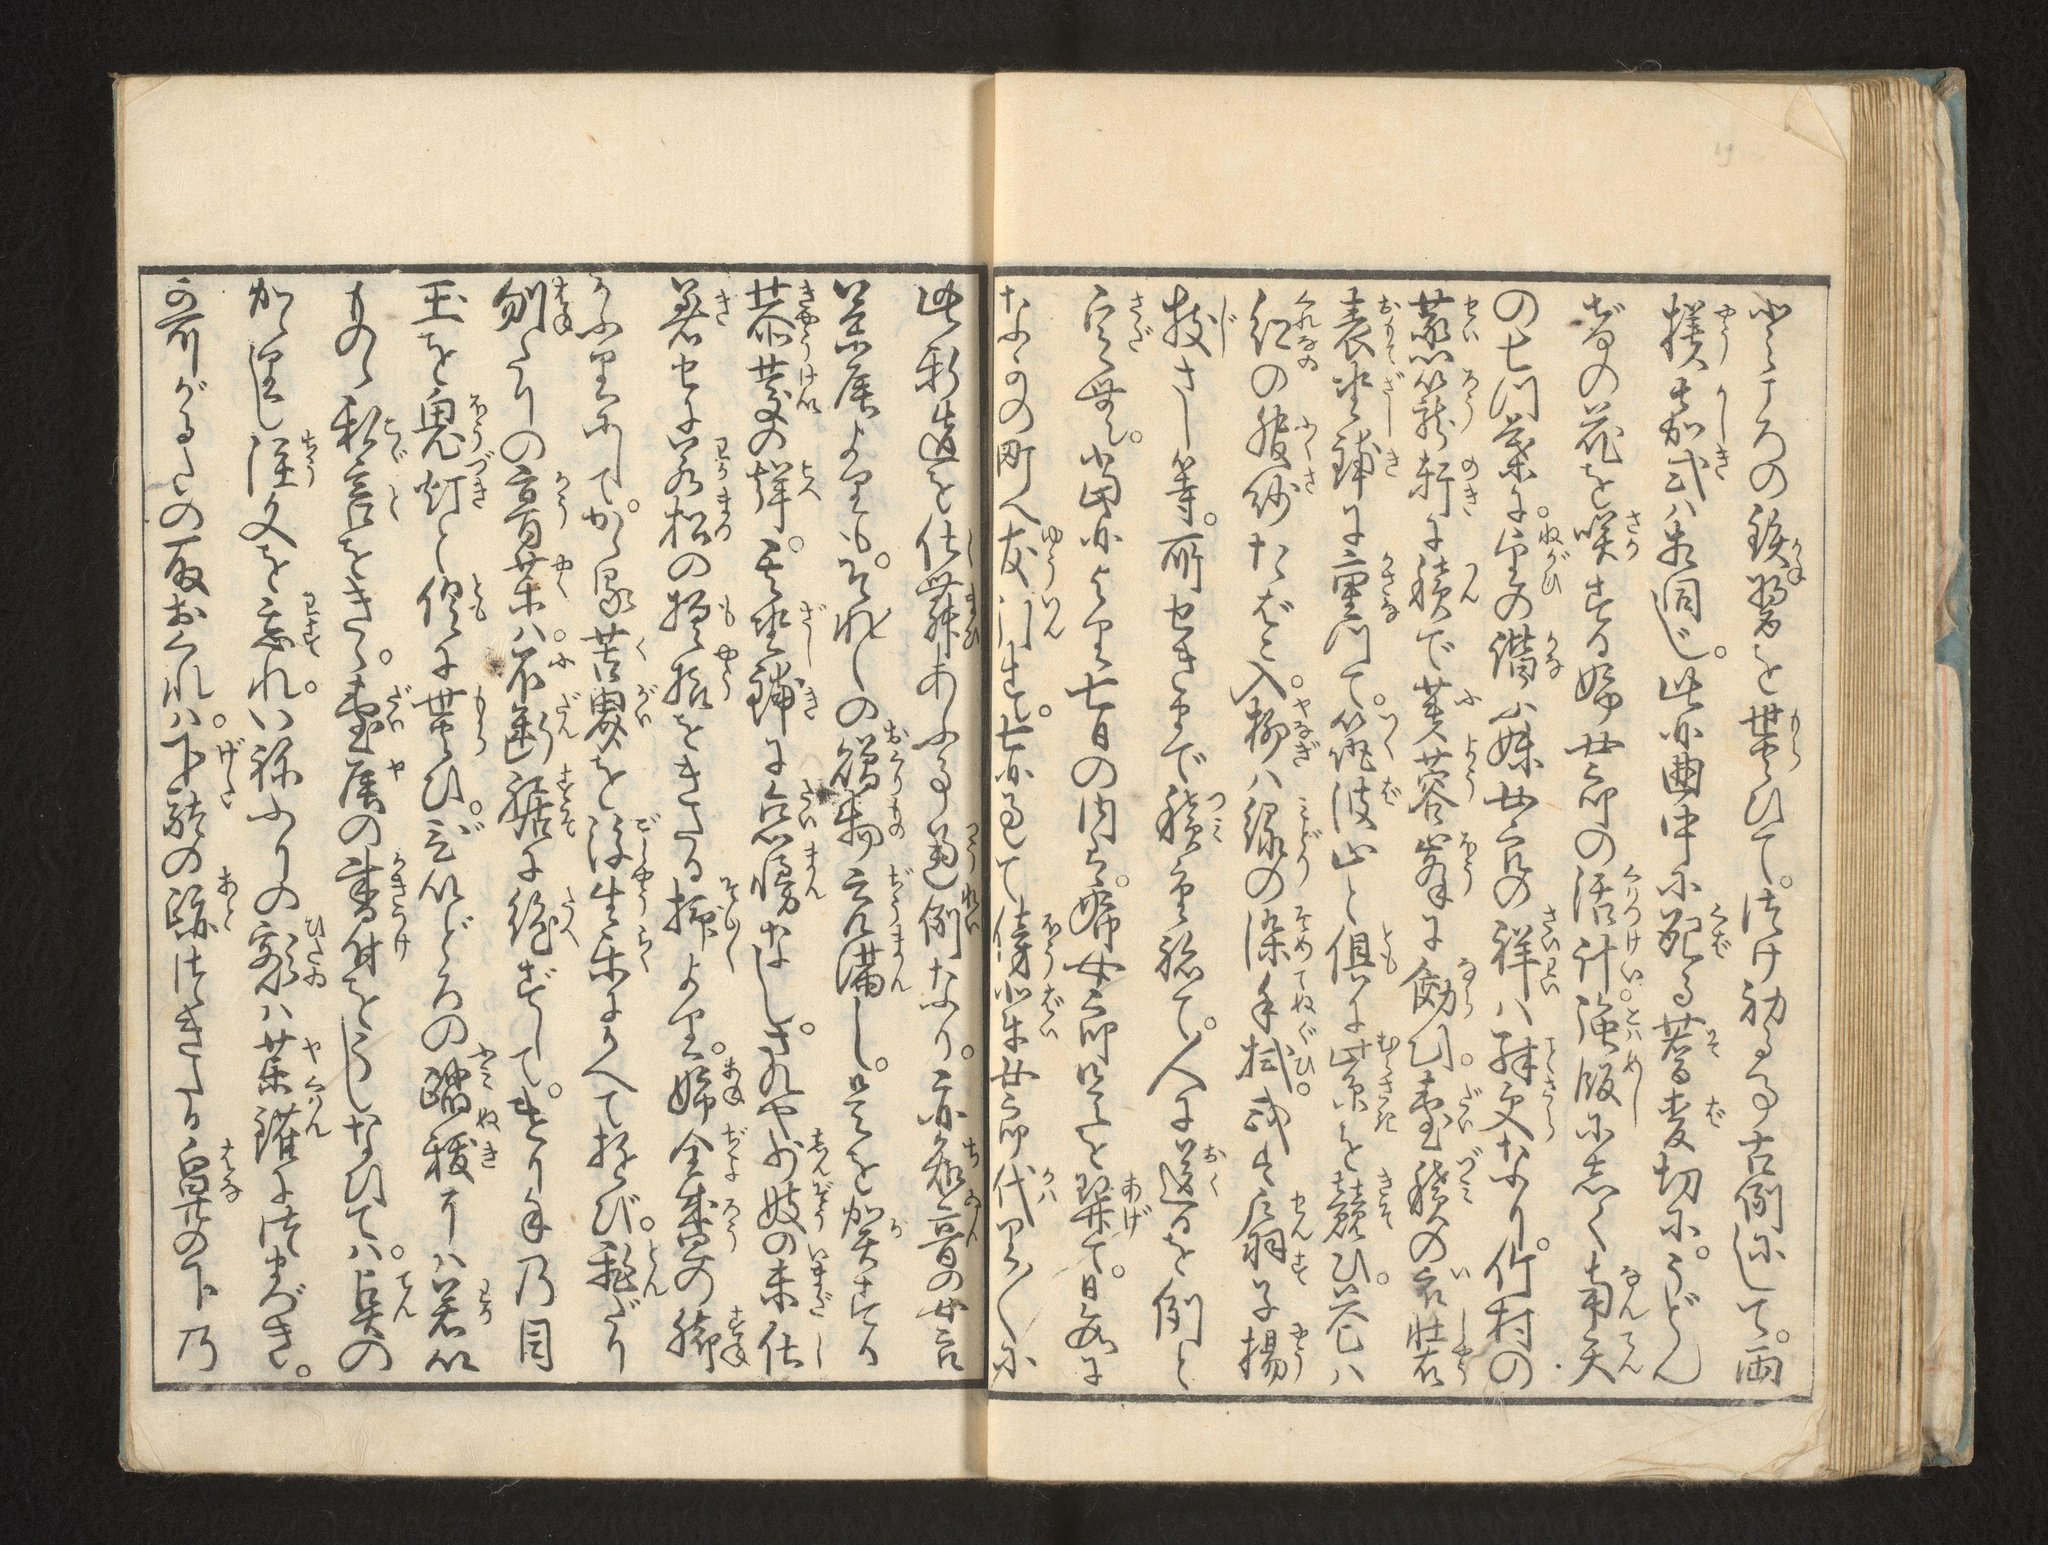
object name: page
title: Tekst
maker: jippensha ikku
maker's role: schrijver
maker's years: 1765-1831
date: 1804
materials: paper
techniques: woodcut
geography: edo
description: Pagina 36 en 37 van deel één van Utamaro`s boek: Gebeurtenissen in de lusthuizen gedurende het jaar.